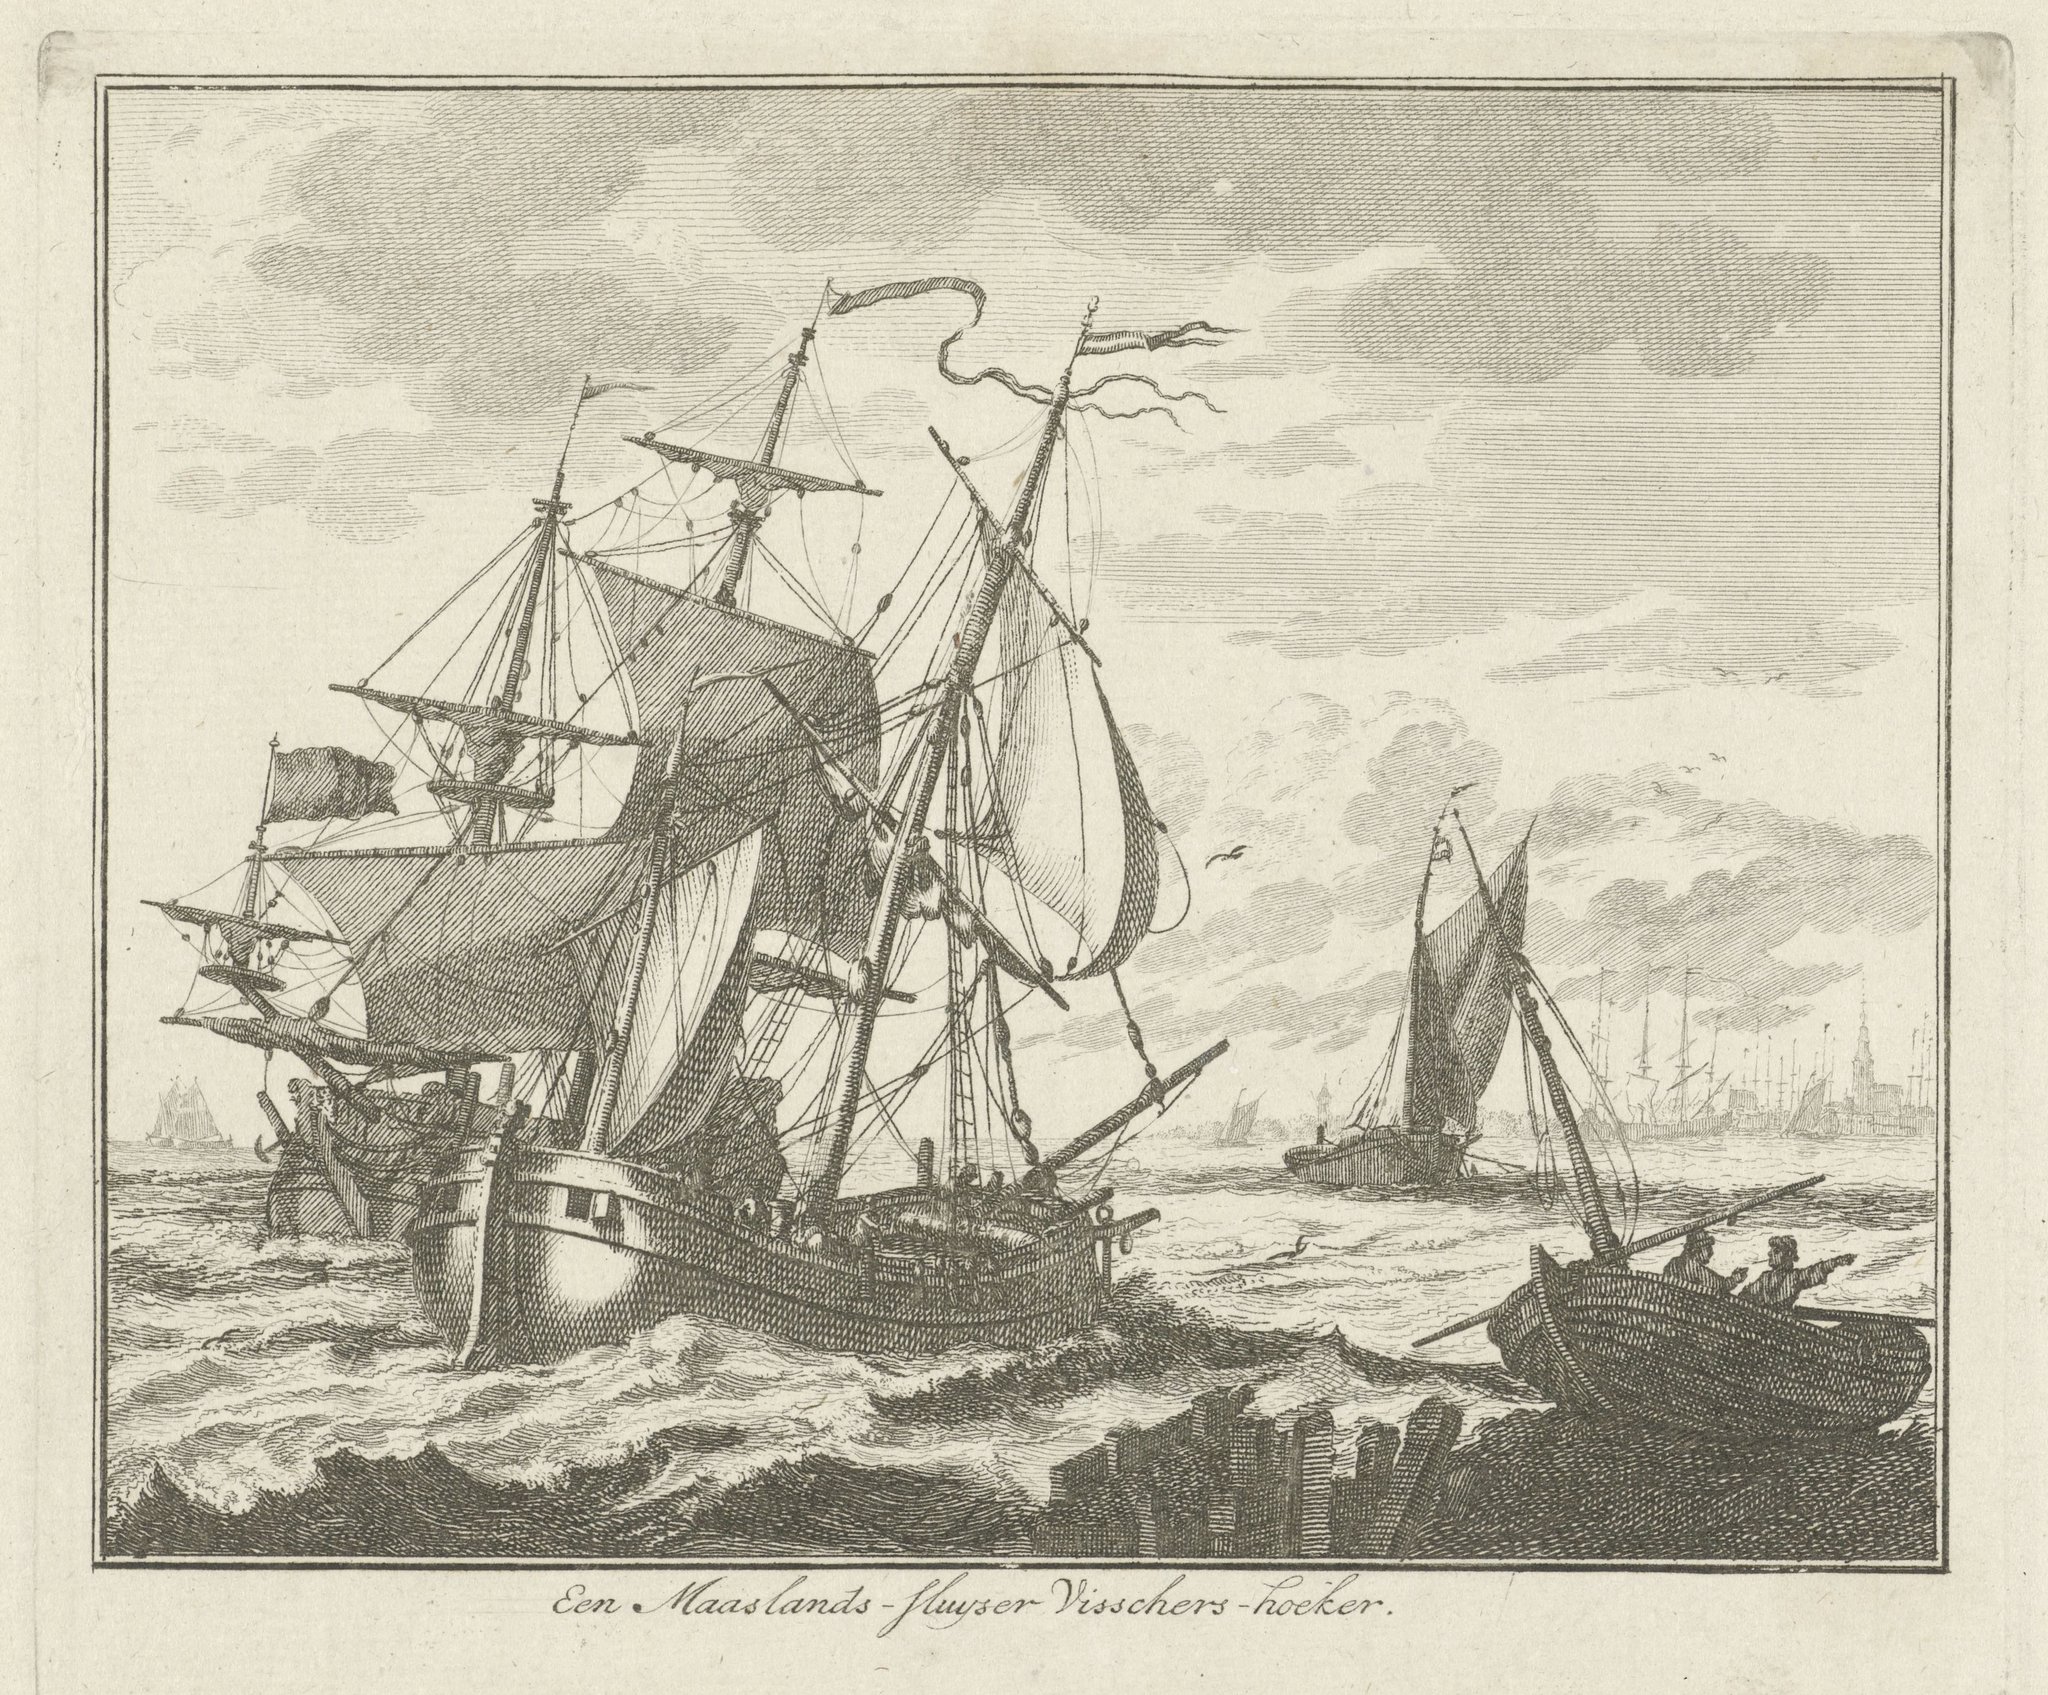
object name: print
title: Hoeker op het water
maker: adolf van der laan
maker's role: draughtsman, print maker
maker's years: 1689-1742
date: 1694-1755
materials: paper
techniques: etching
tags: sailing-ship, sailing-boat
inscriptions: collector's mark: Lugt 2228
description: Een varende hoeker, rechts twee figuren in een roeiboot. In de verte ligt een haven en een stad met kerktoren.